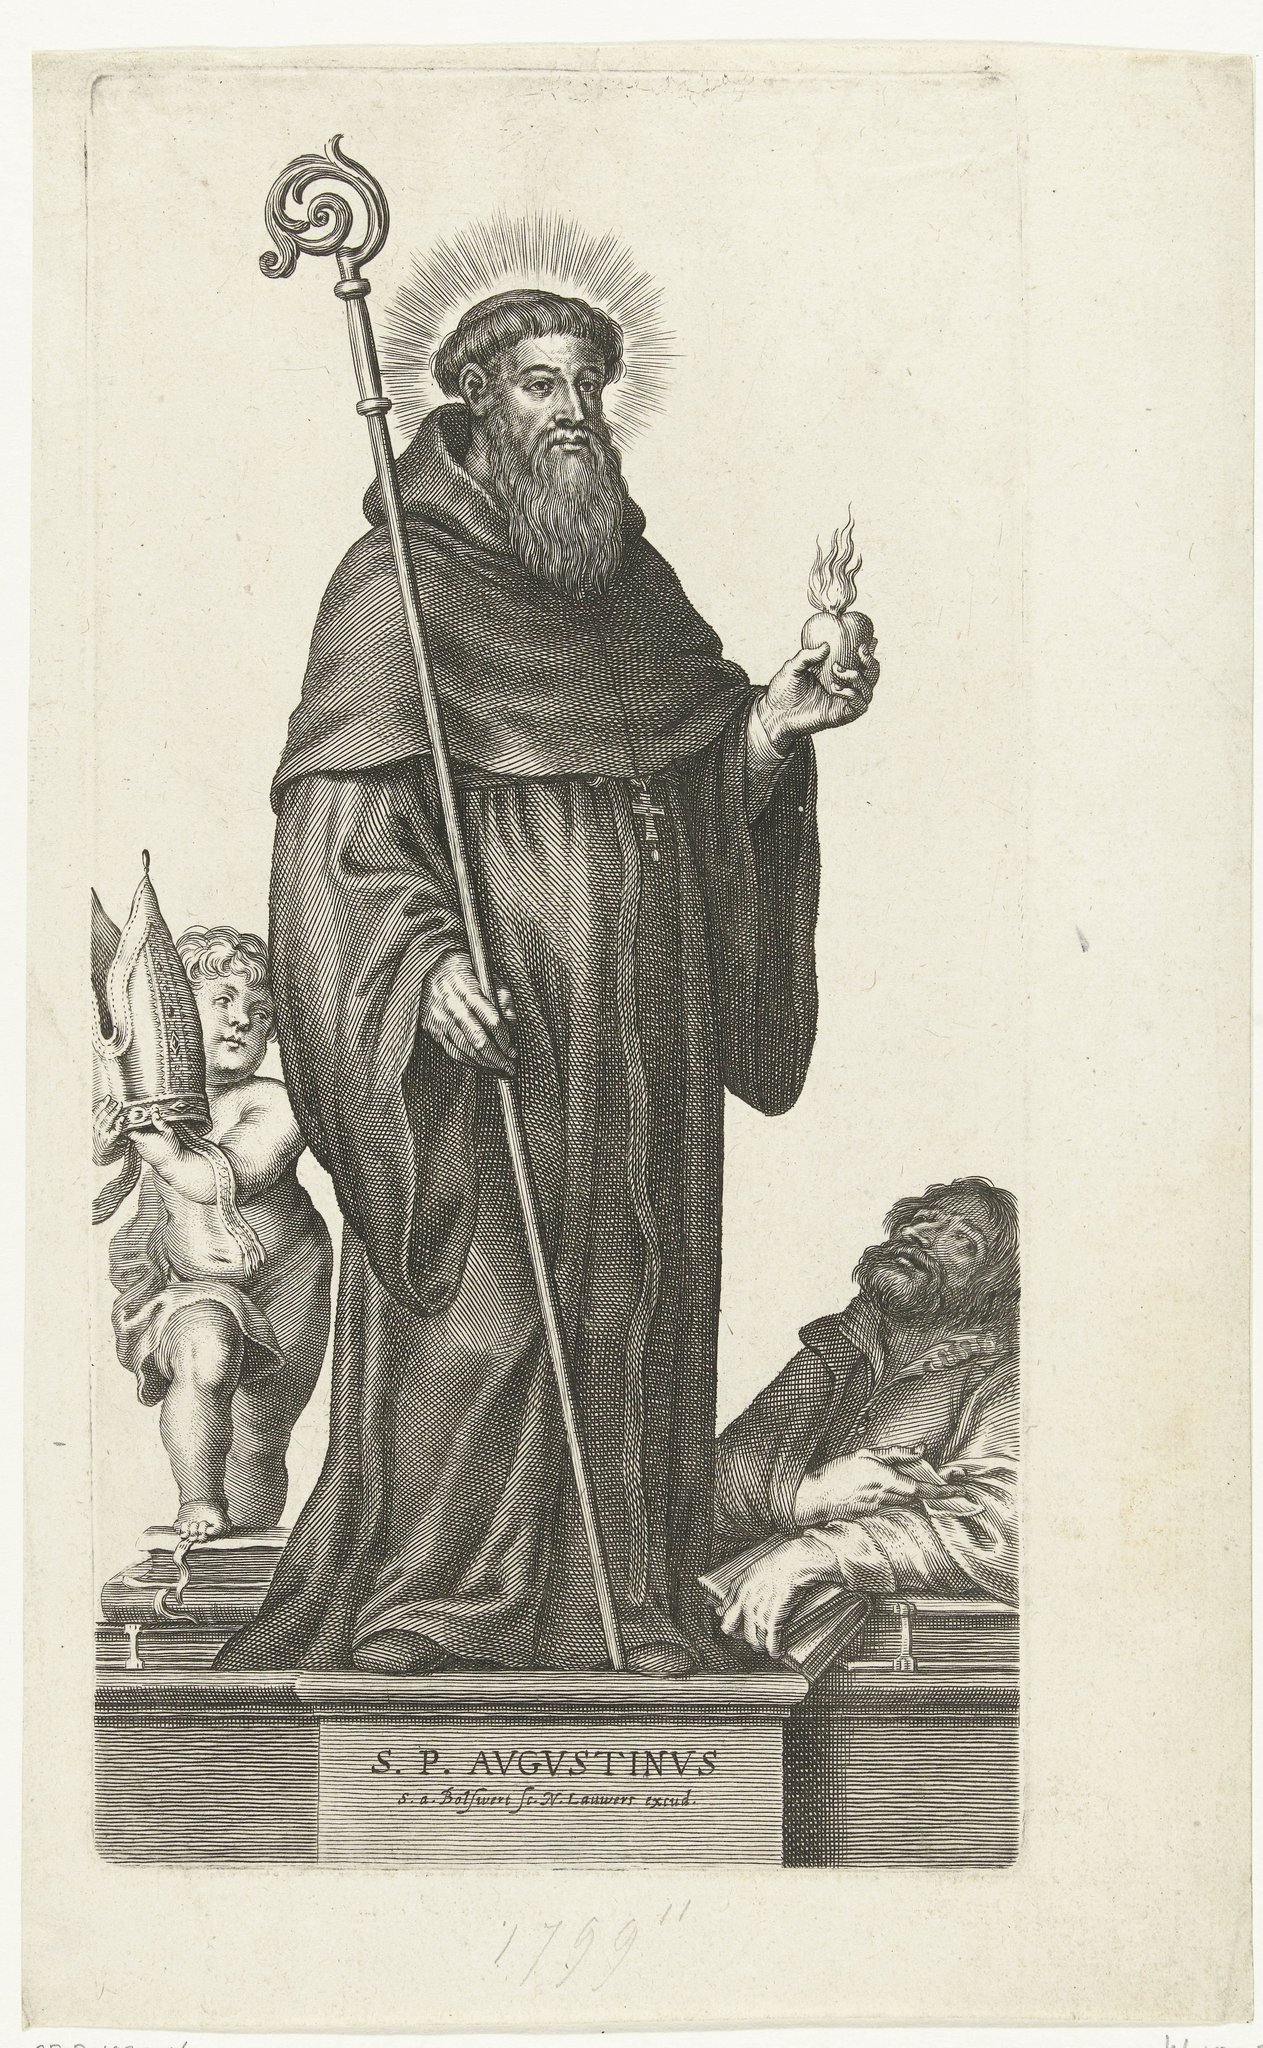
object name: print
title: Heilige Augustinus van Hippo met brandend hart en gelovige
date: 1596-1659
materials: paper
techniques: engraving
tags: augustine, bishop of hippo; possible attributes: arrows piercing his breast, book, child with spoon, flaming heart, heart (pierced with arrows), pen, devotion, piety; 'divotione' (ripa)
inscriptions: collector's mark: Lugt 2228